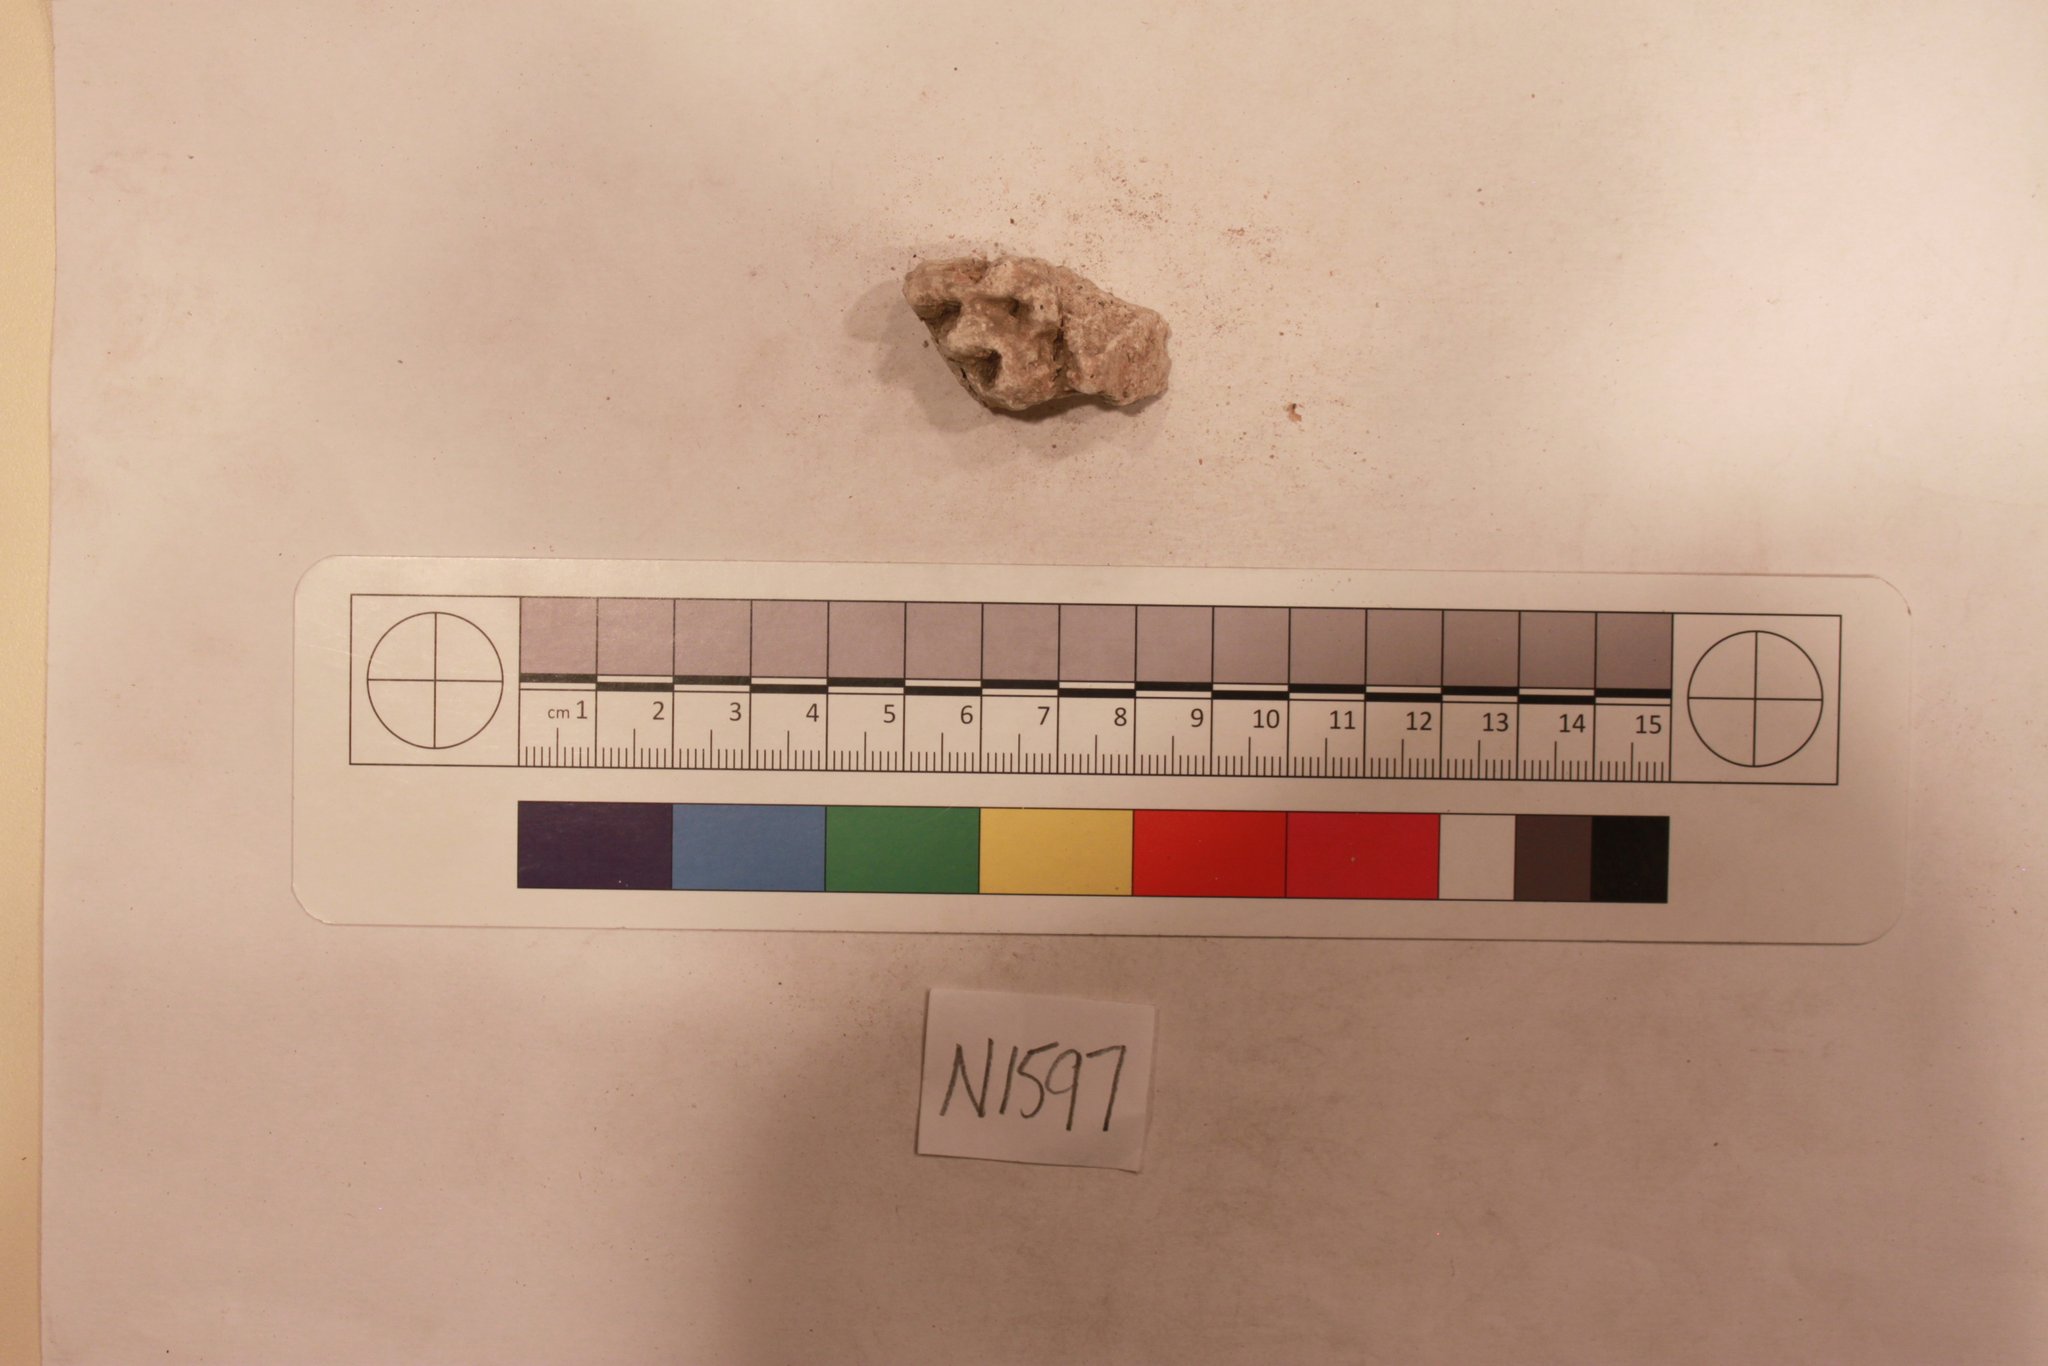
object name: fragment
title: Stucco Fragment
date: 701-1200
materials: plaster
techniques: carving, painting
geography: iran